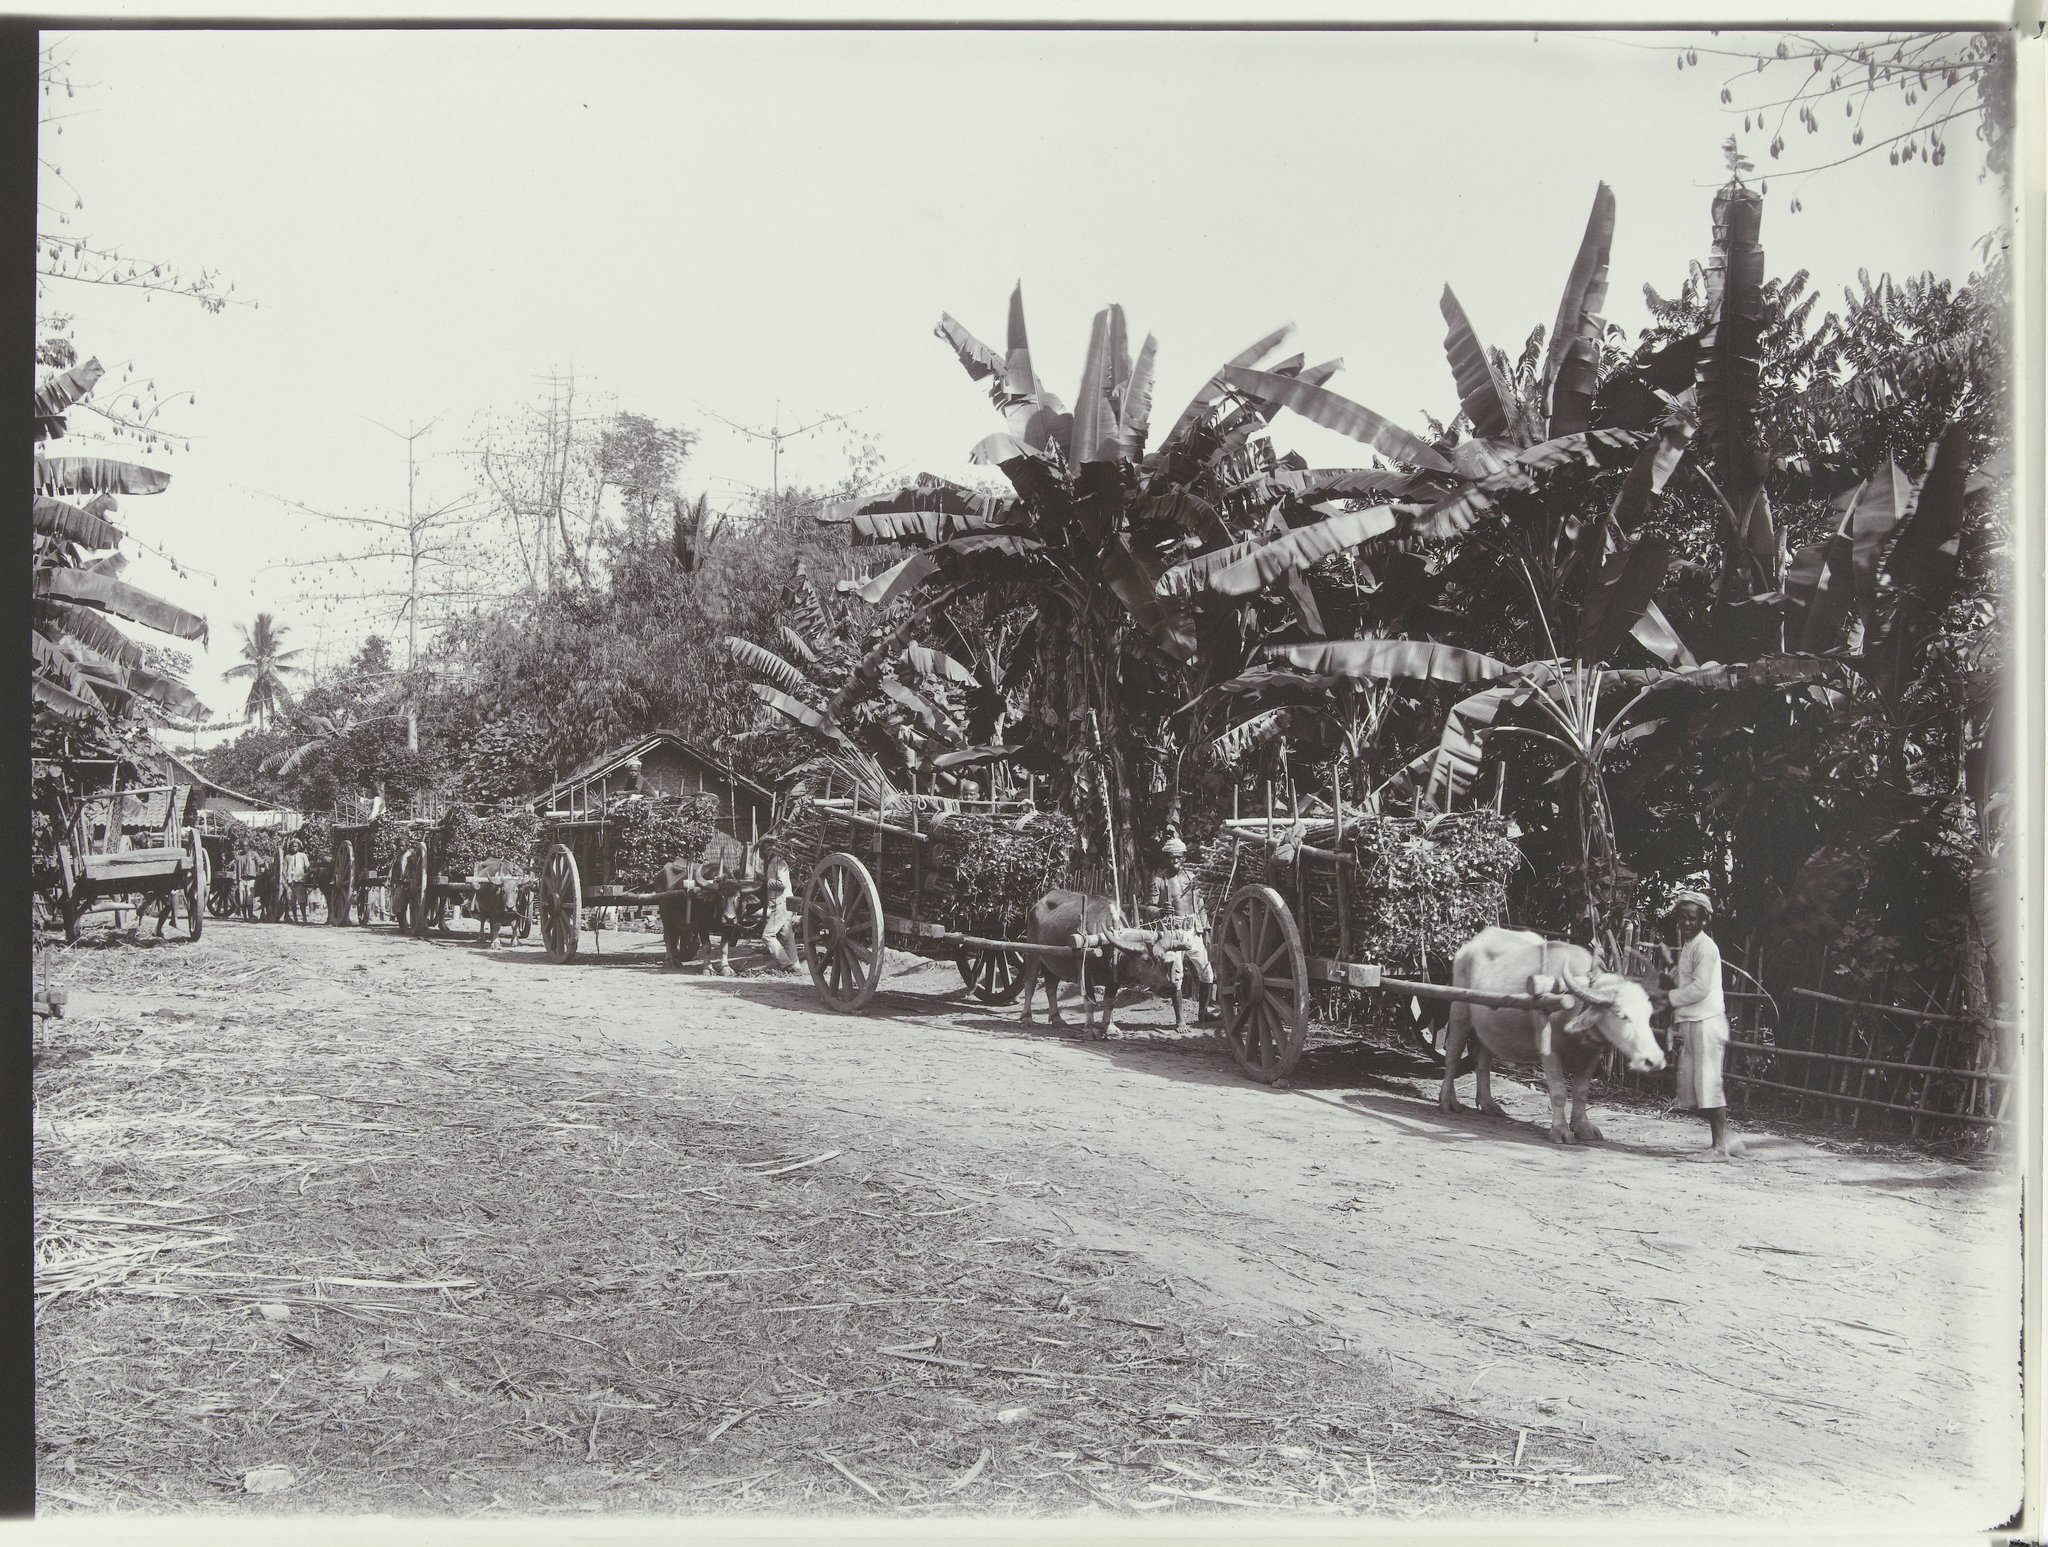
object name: photograph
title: Riettransport met ossen op de suikeronderneming Nieuw Tersana, Cheribon, voormalig Nederlands-Indië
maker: onnes kurkdjian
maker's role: fotograaf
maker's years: 1851-1903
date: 1890-1935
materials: paper, photographic support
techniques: gelatin silver print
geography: cirebon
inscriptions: annotation: ‘Nieuw Tersana’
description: Riettransport met karren getrokken door ossen op de suikeronderneming Nieuw Tersana, Cheribon, voormalig Nederlands-Indië